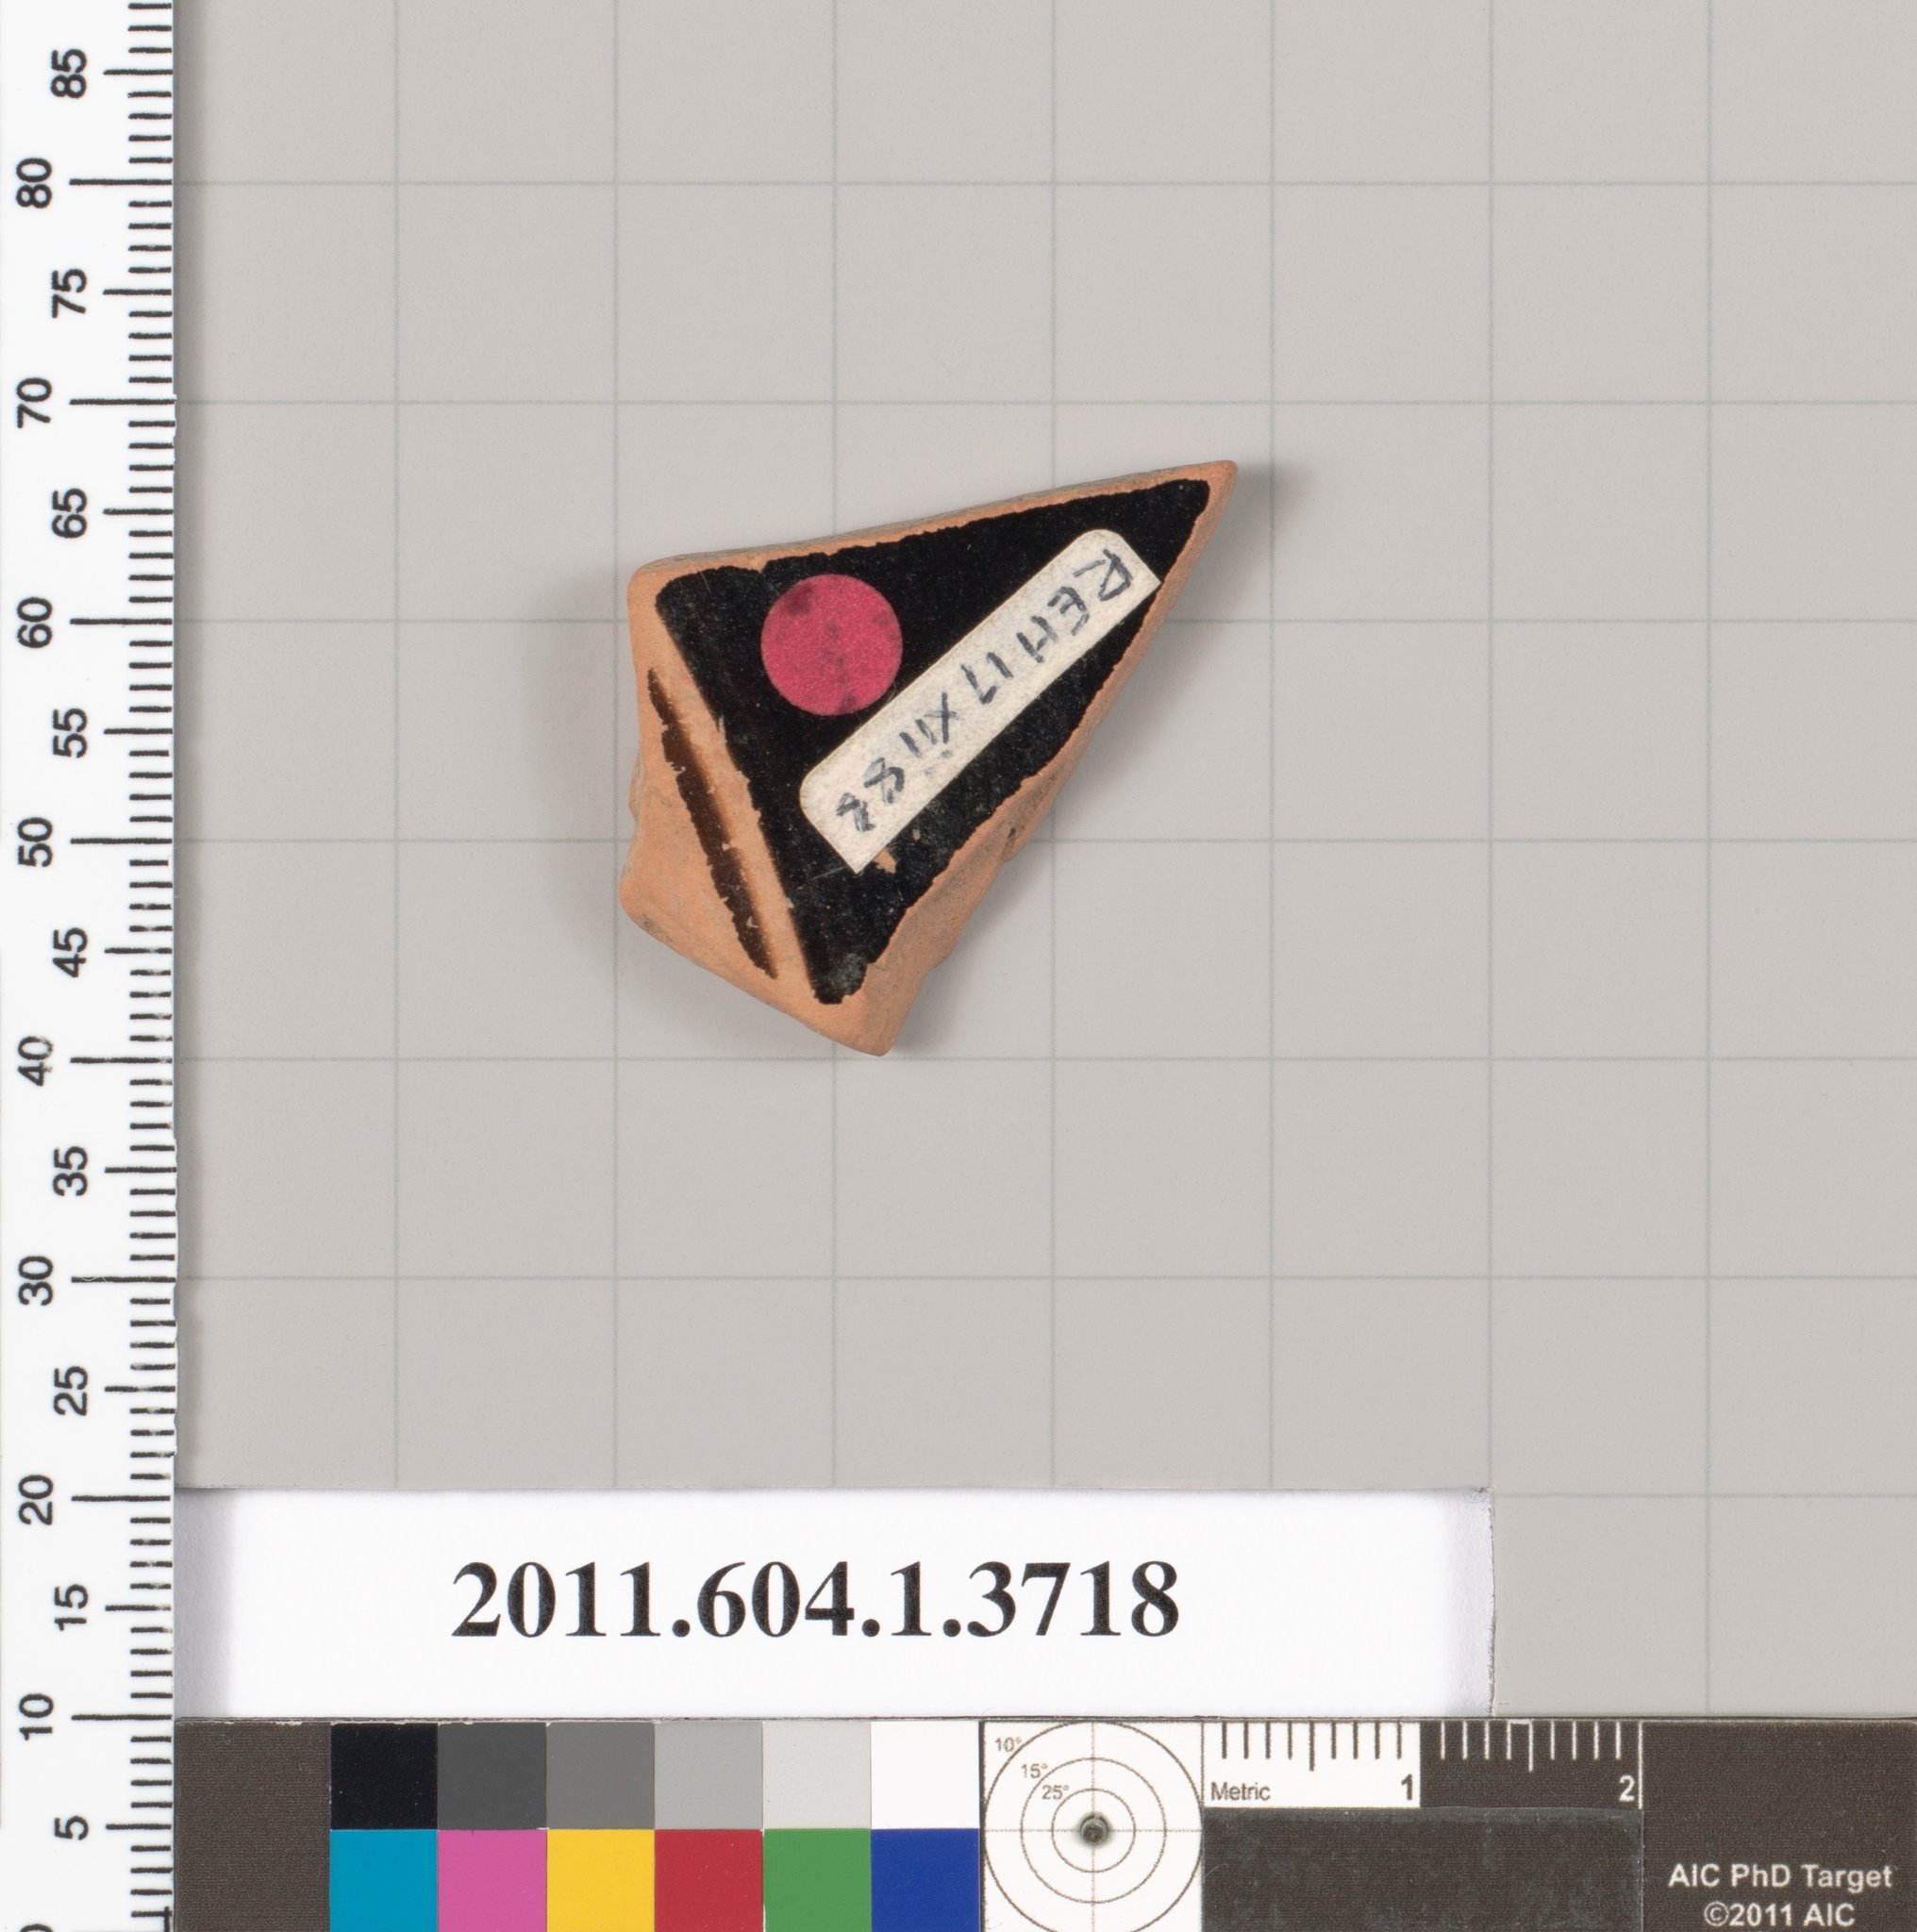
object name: kylix fragment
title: Terracotta fragment of a kylix (drinking cup)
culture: greek, attic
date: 500-480 BCE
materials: terracotta